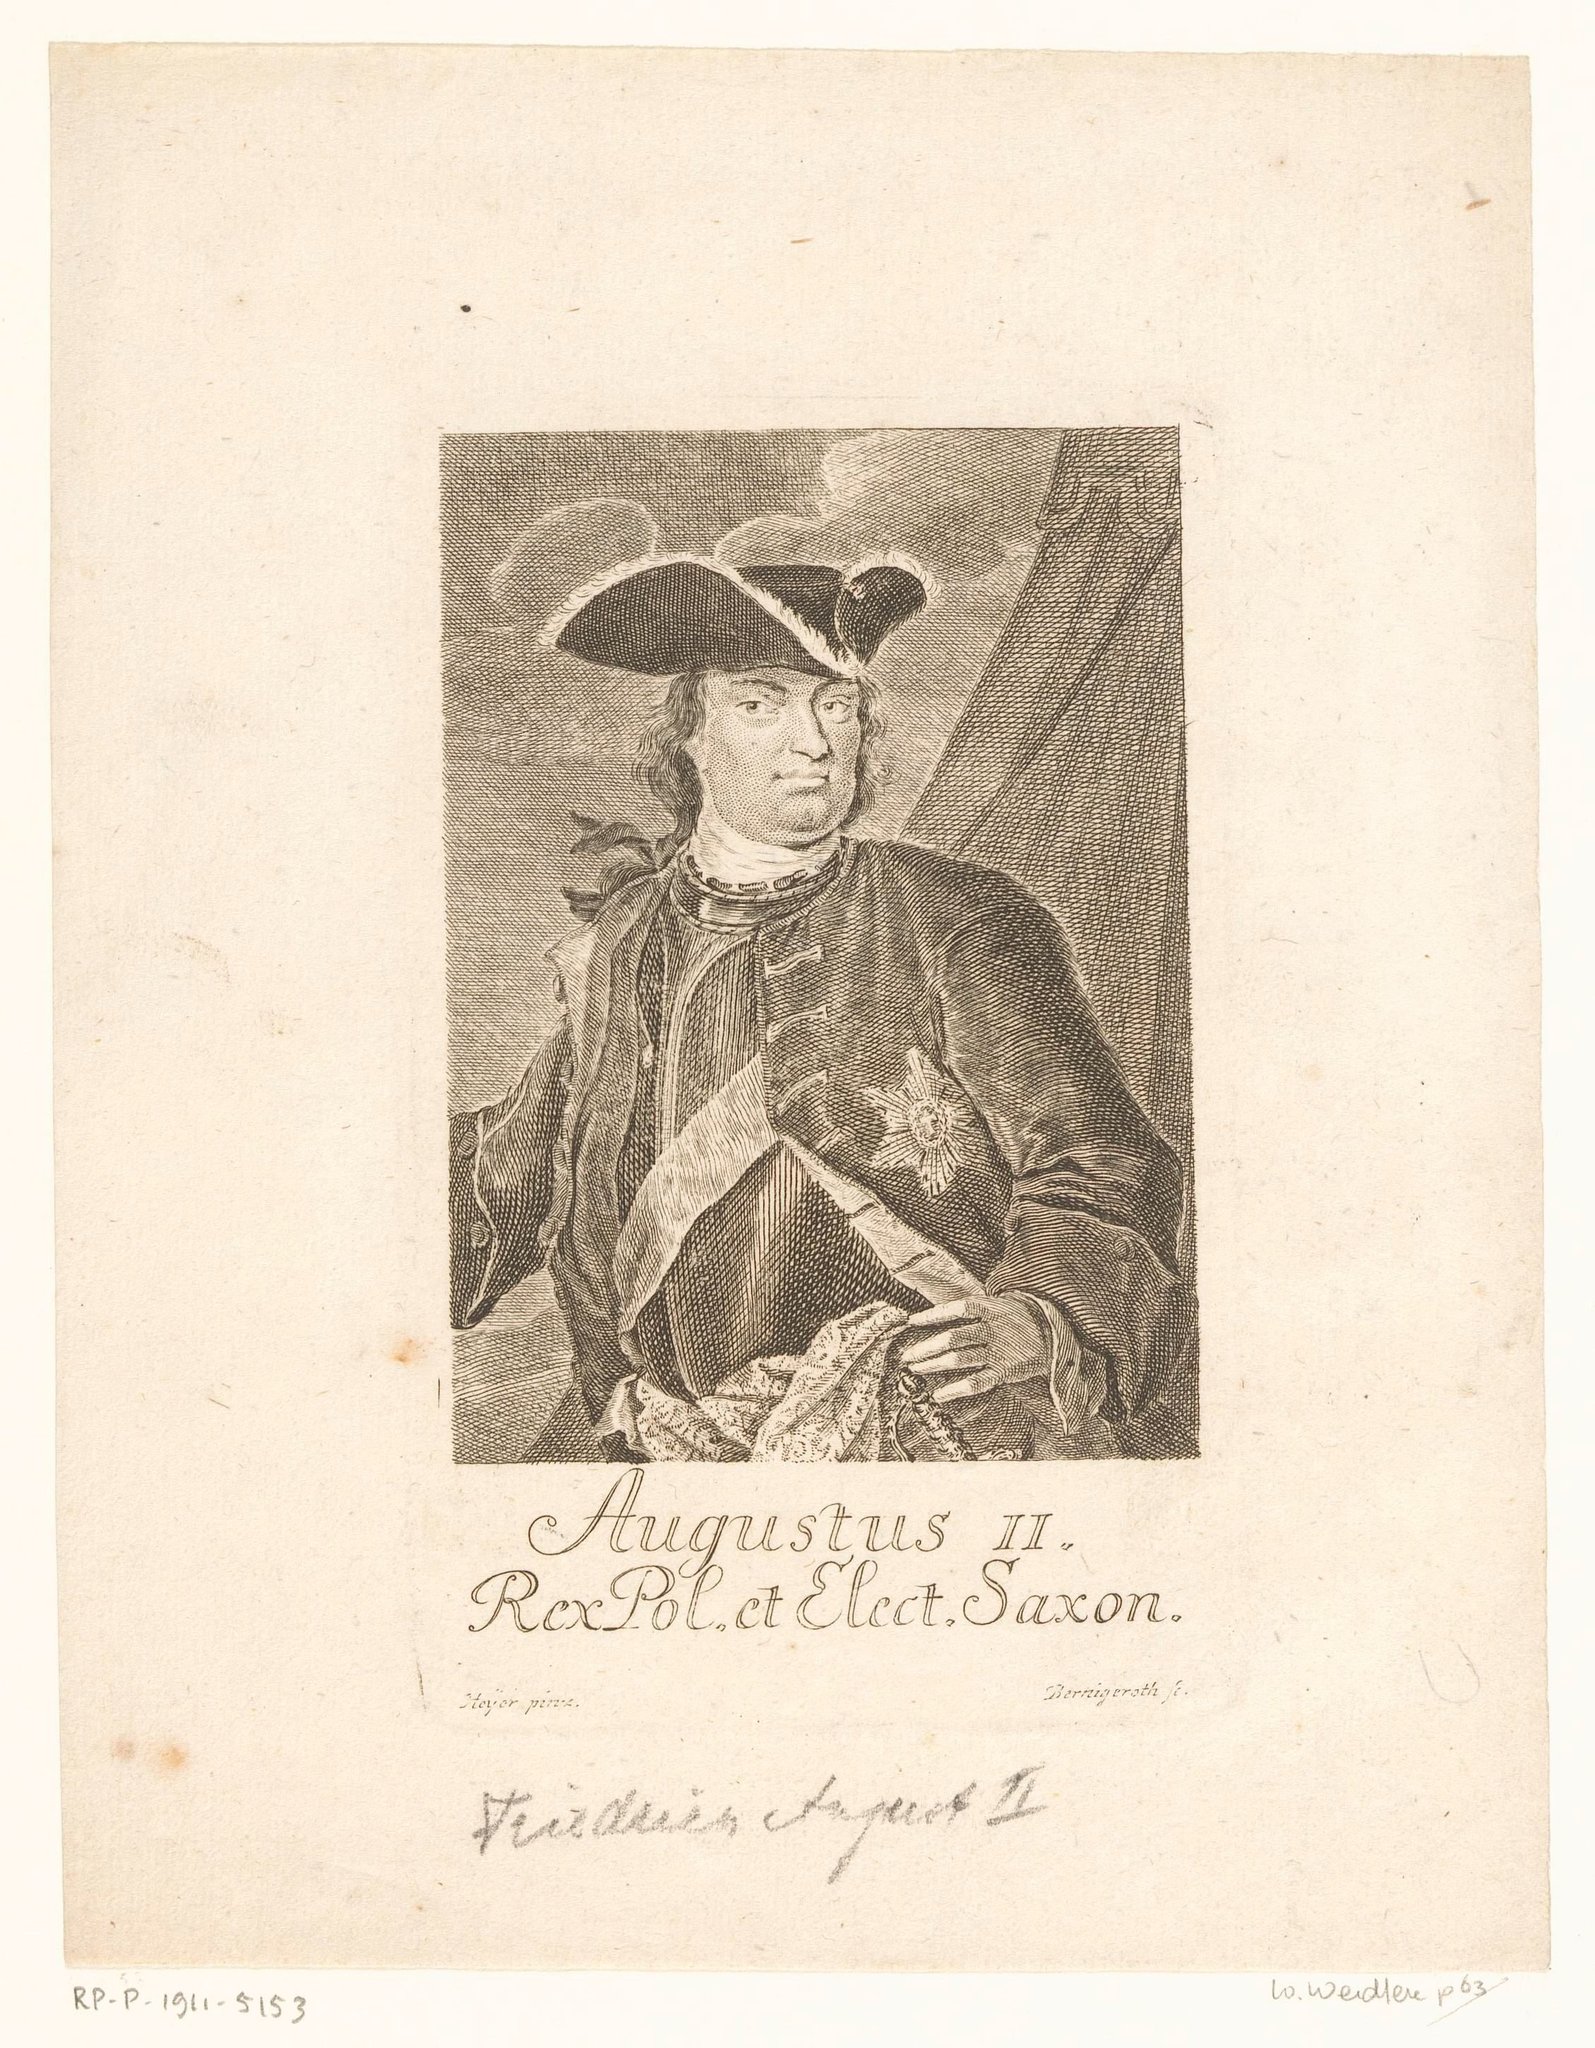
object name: print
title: Portret van August II de Sterke, koning van Polen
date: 1697-1733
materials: paper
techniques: engraving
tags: august ii (king of poland), knighthood order (with name) - insignia of a knighthood order, e.g.: badge, chain (with name of order), historical persons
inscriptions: collector's mark: Lugt 2228